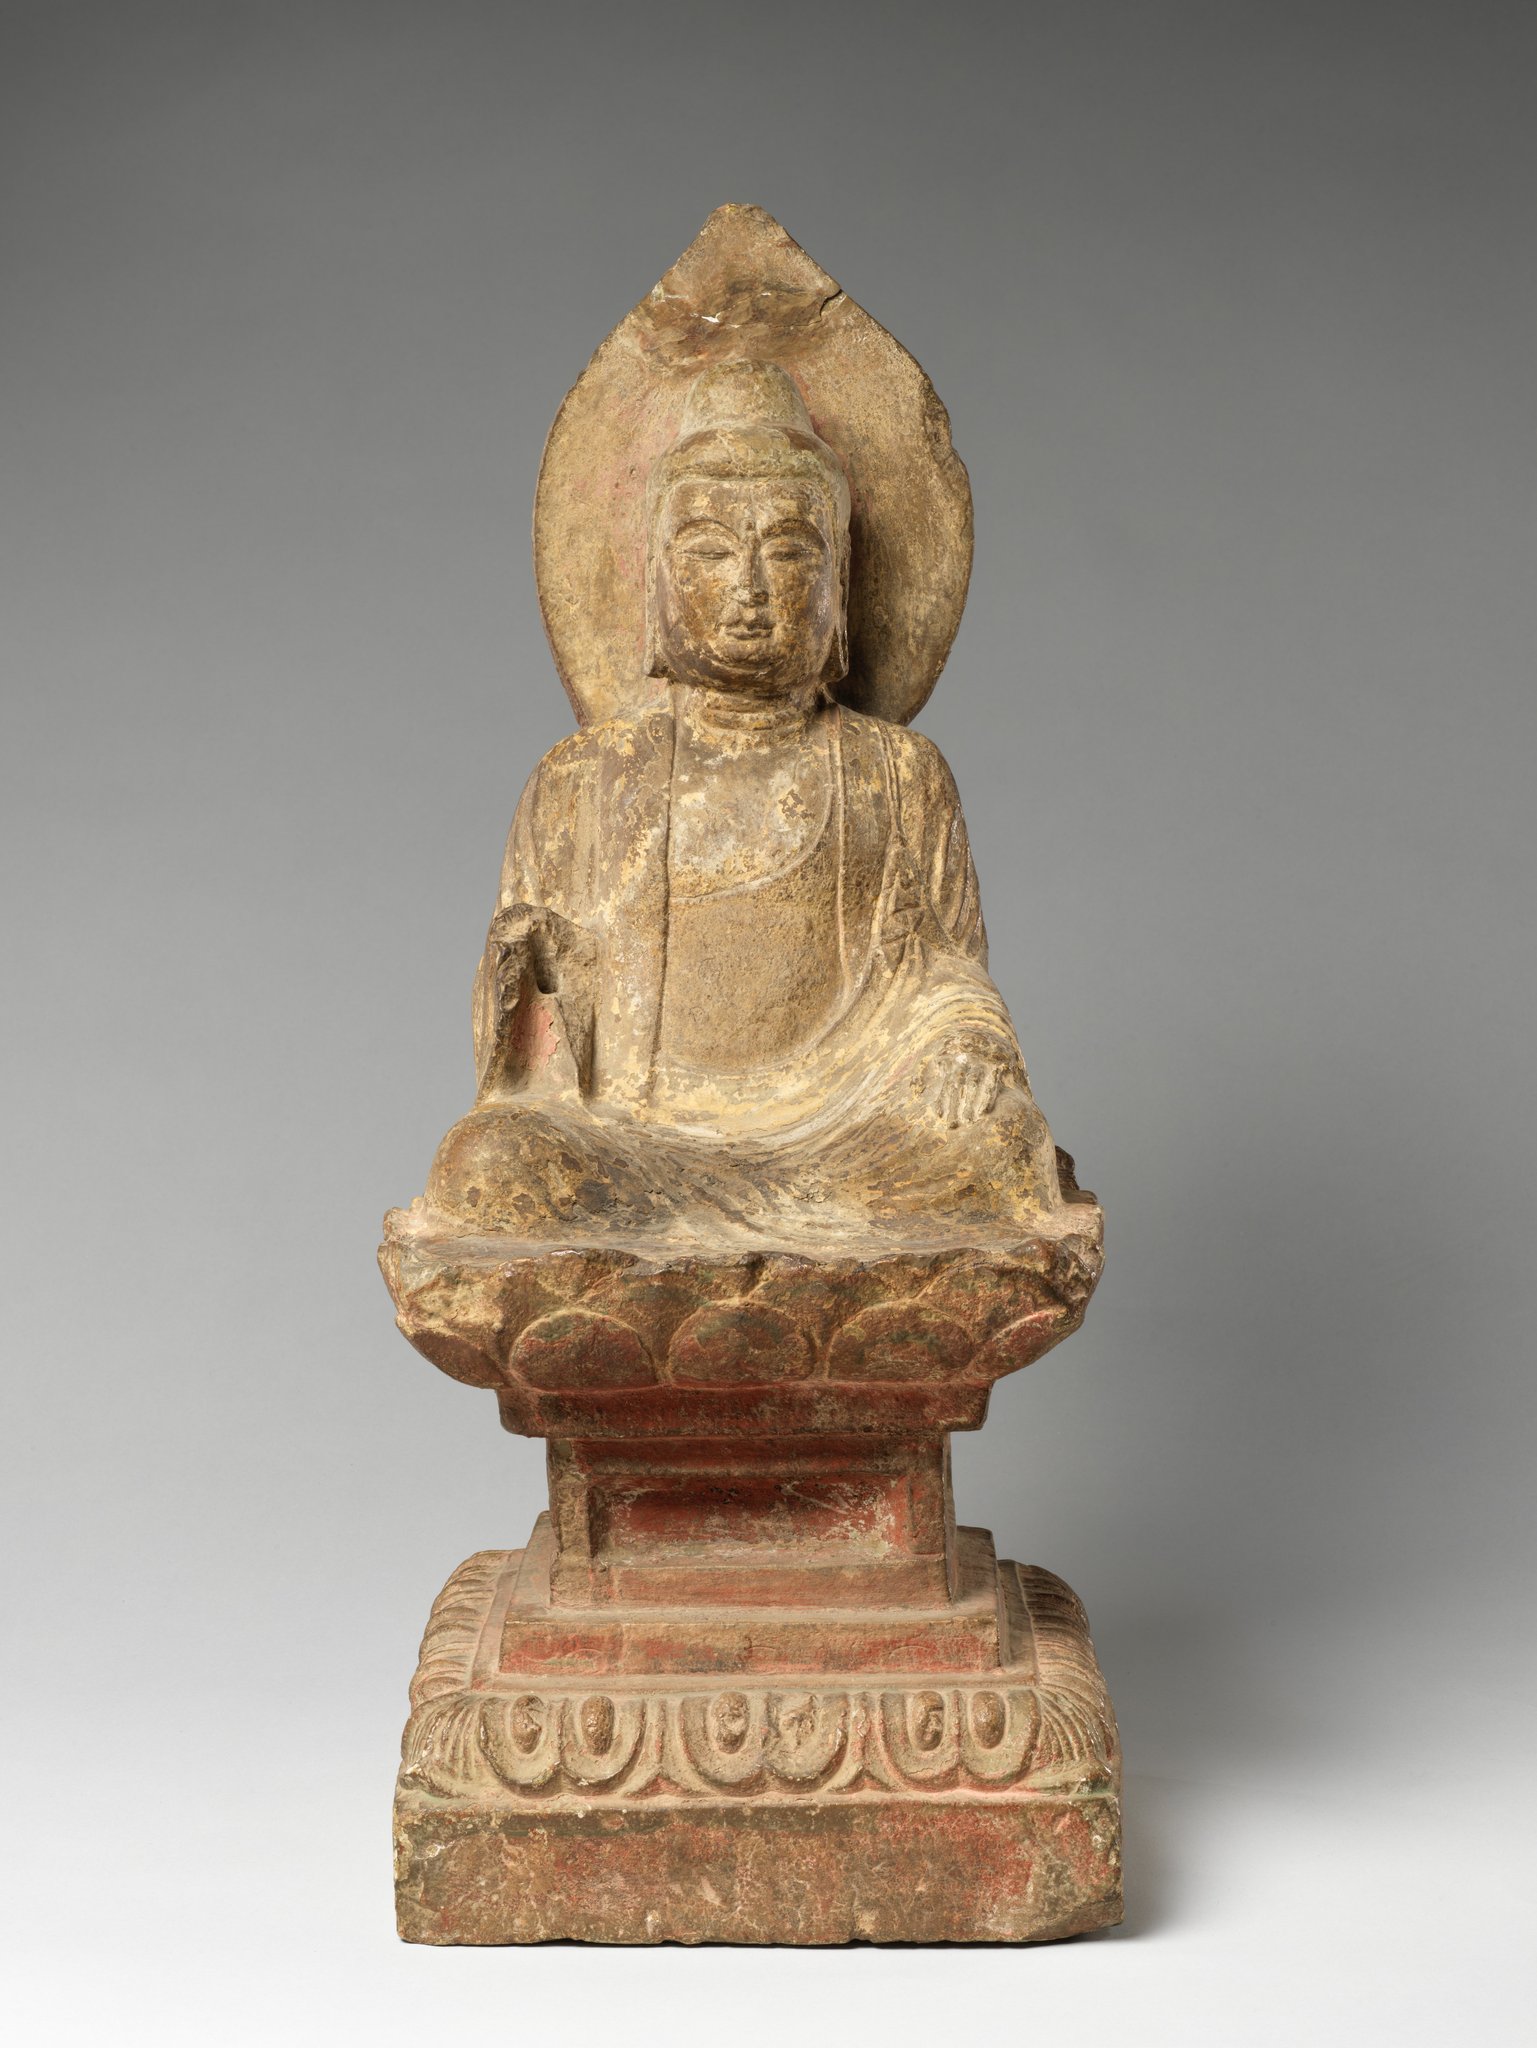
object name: figure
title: Seated Amida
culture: chinese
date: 618-907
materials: paint, stone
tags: buddha